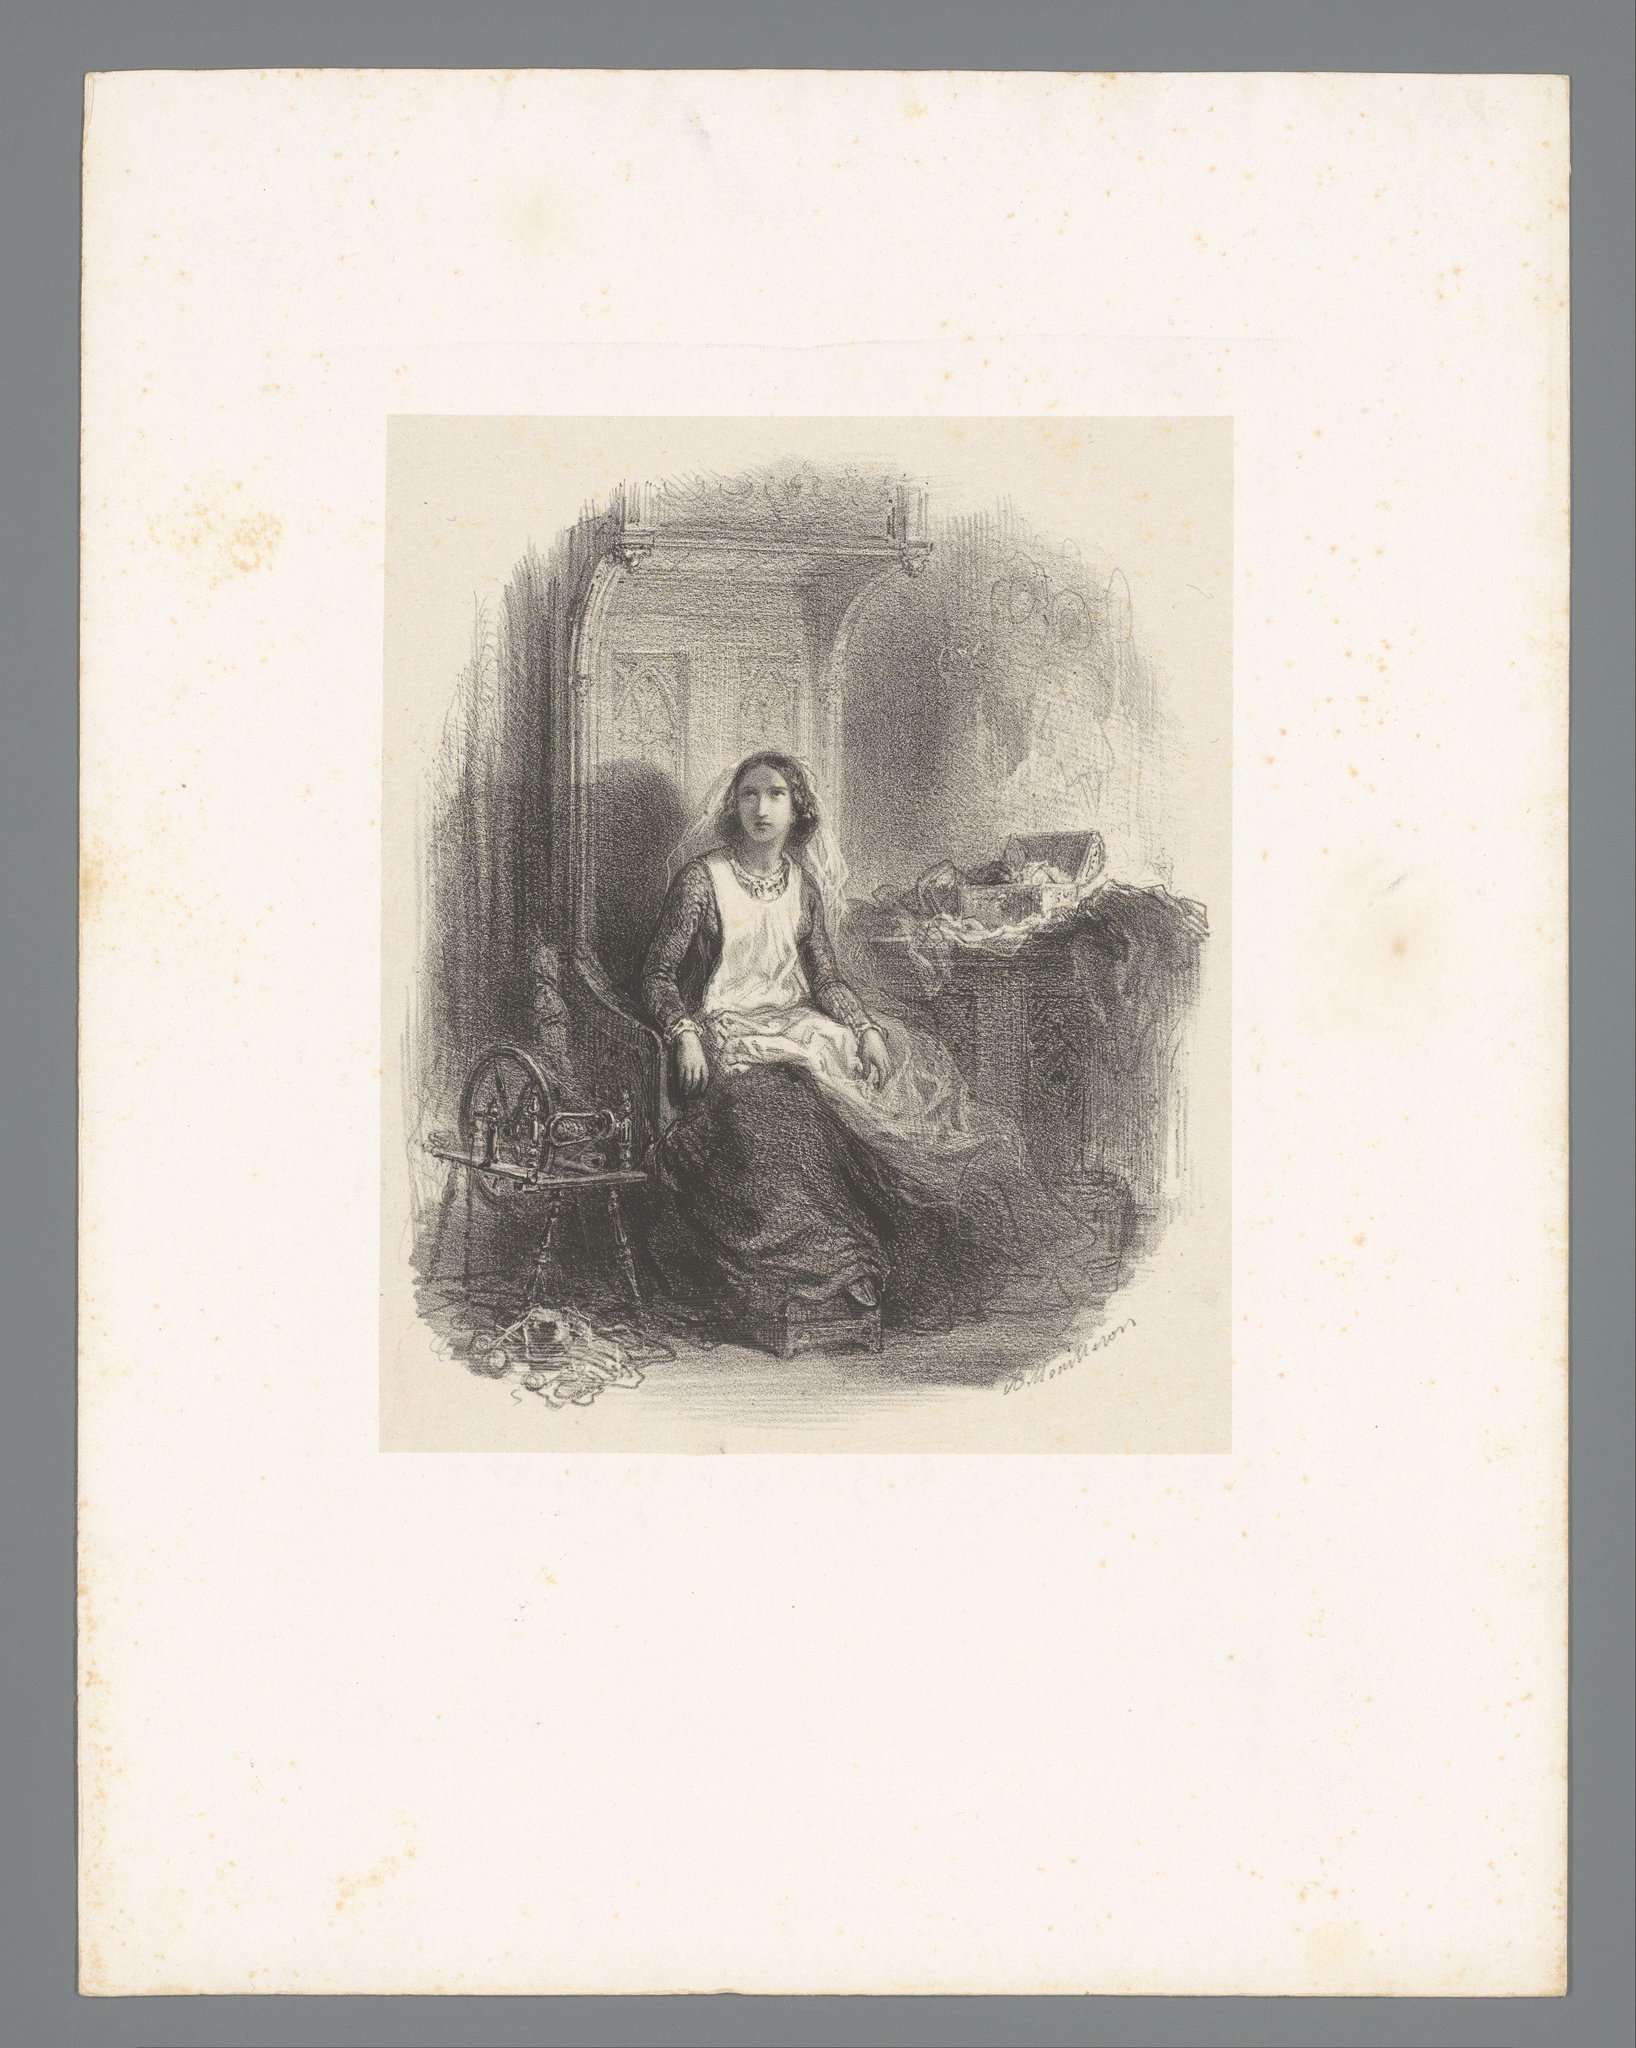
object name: print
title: Jonge vrouw in hoge armstoel aan spinnewiel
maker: adolphe mouilleron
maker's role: draughtsman, print maker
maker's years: 1820-1881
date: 1830-1881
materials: paper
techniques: lithograph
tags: armchair, seat, adult woman, spinning-wheel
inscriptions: collector's mark: Lugt 964